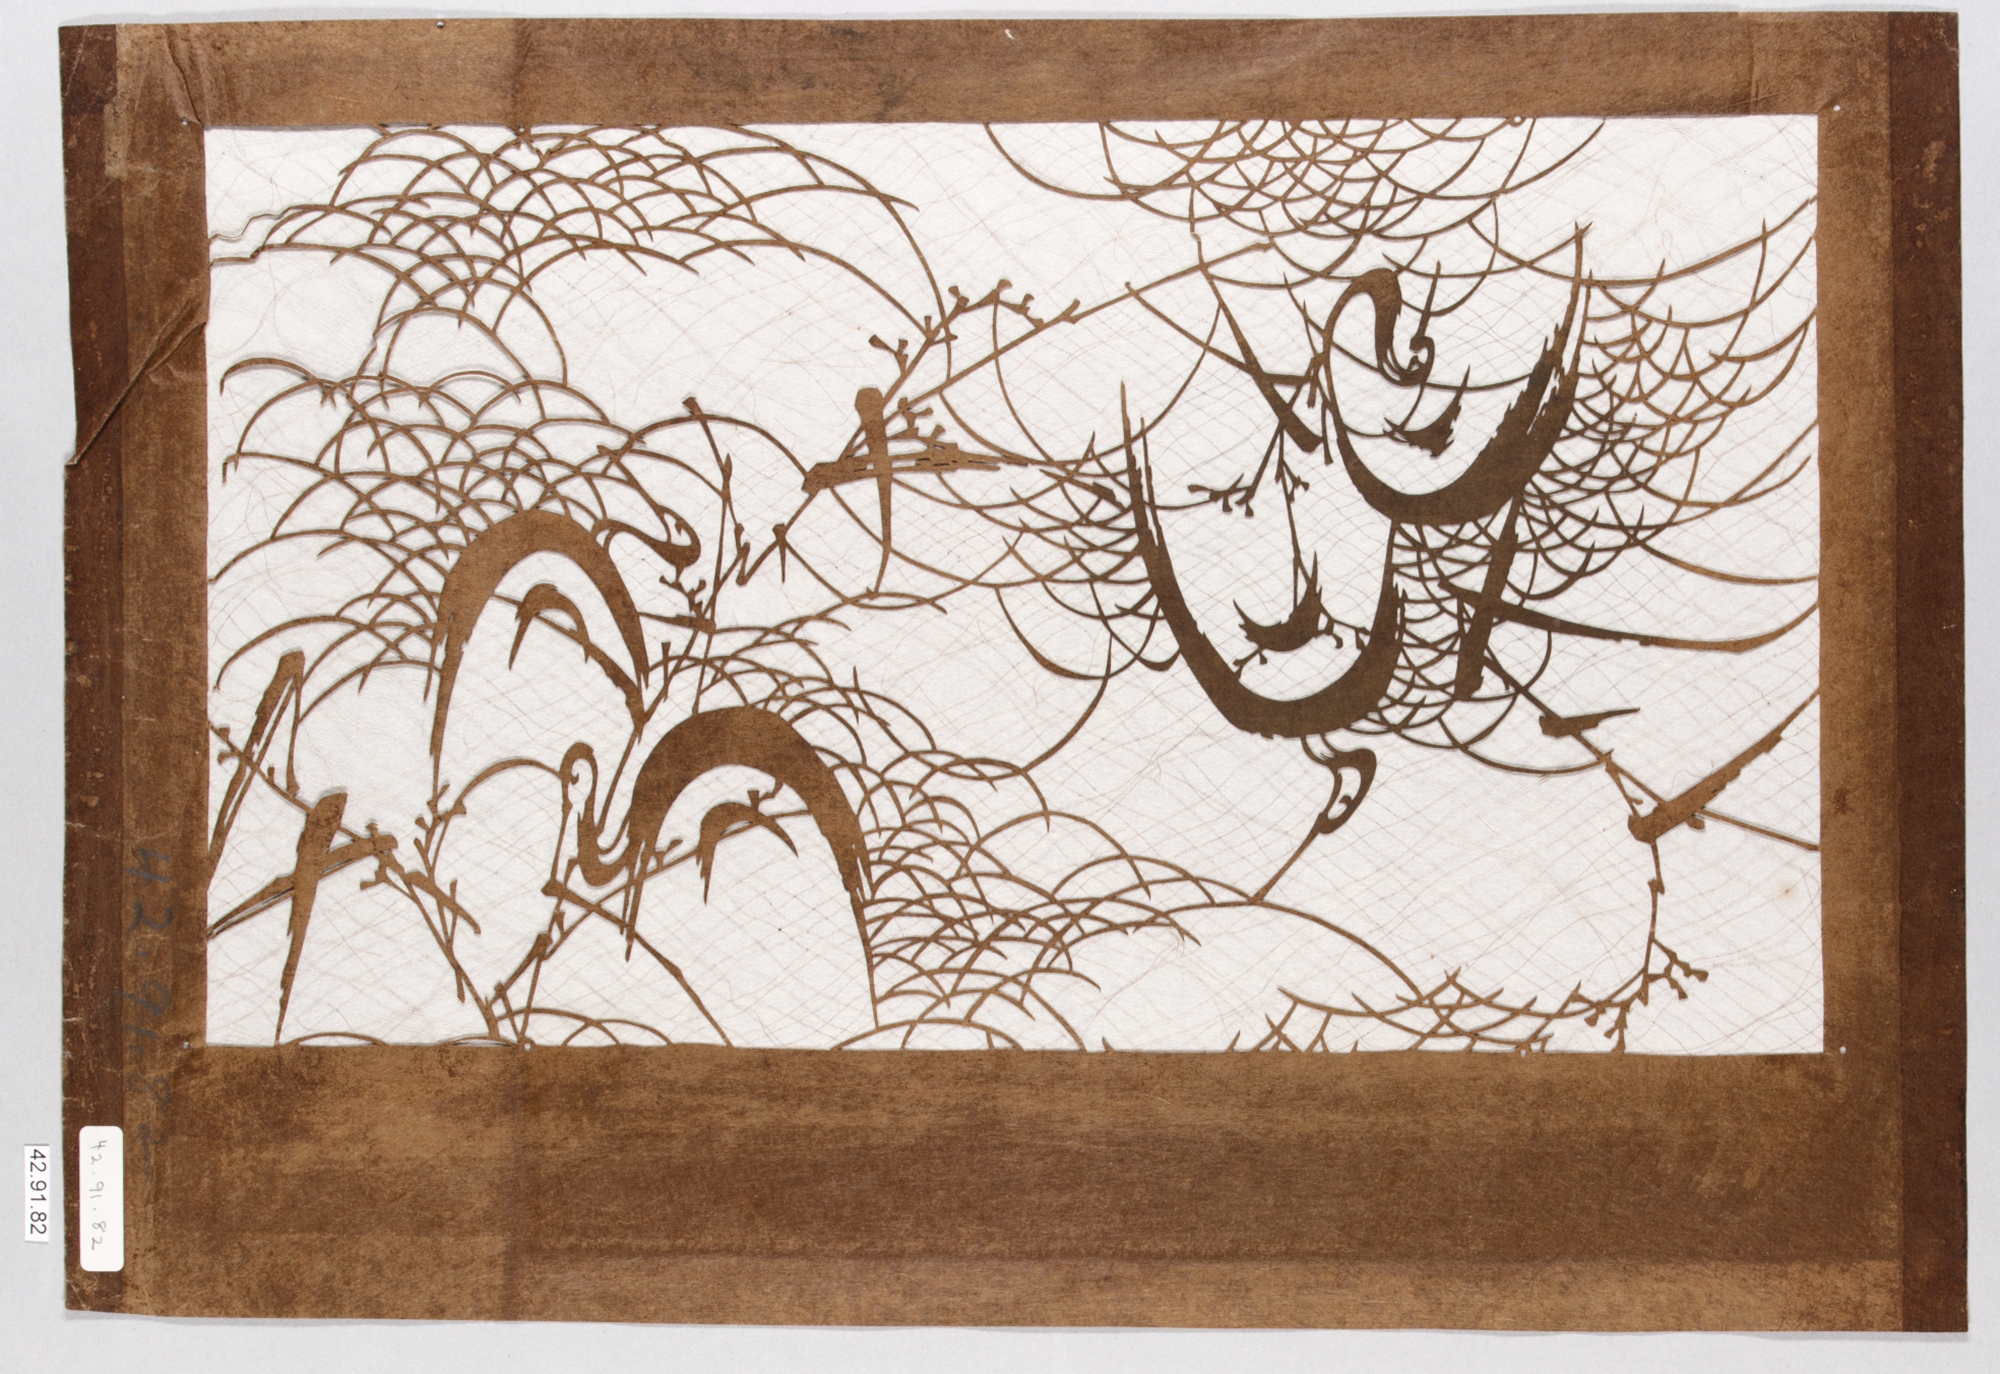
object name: stencil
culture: japanese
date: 1801-1900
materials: paper, silk